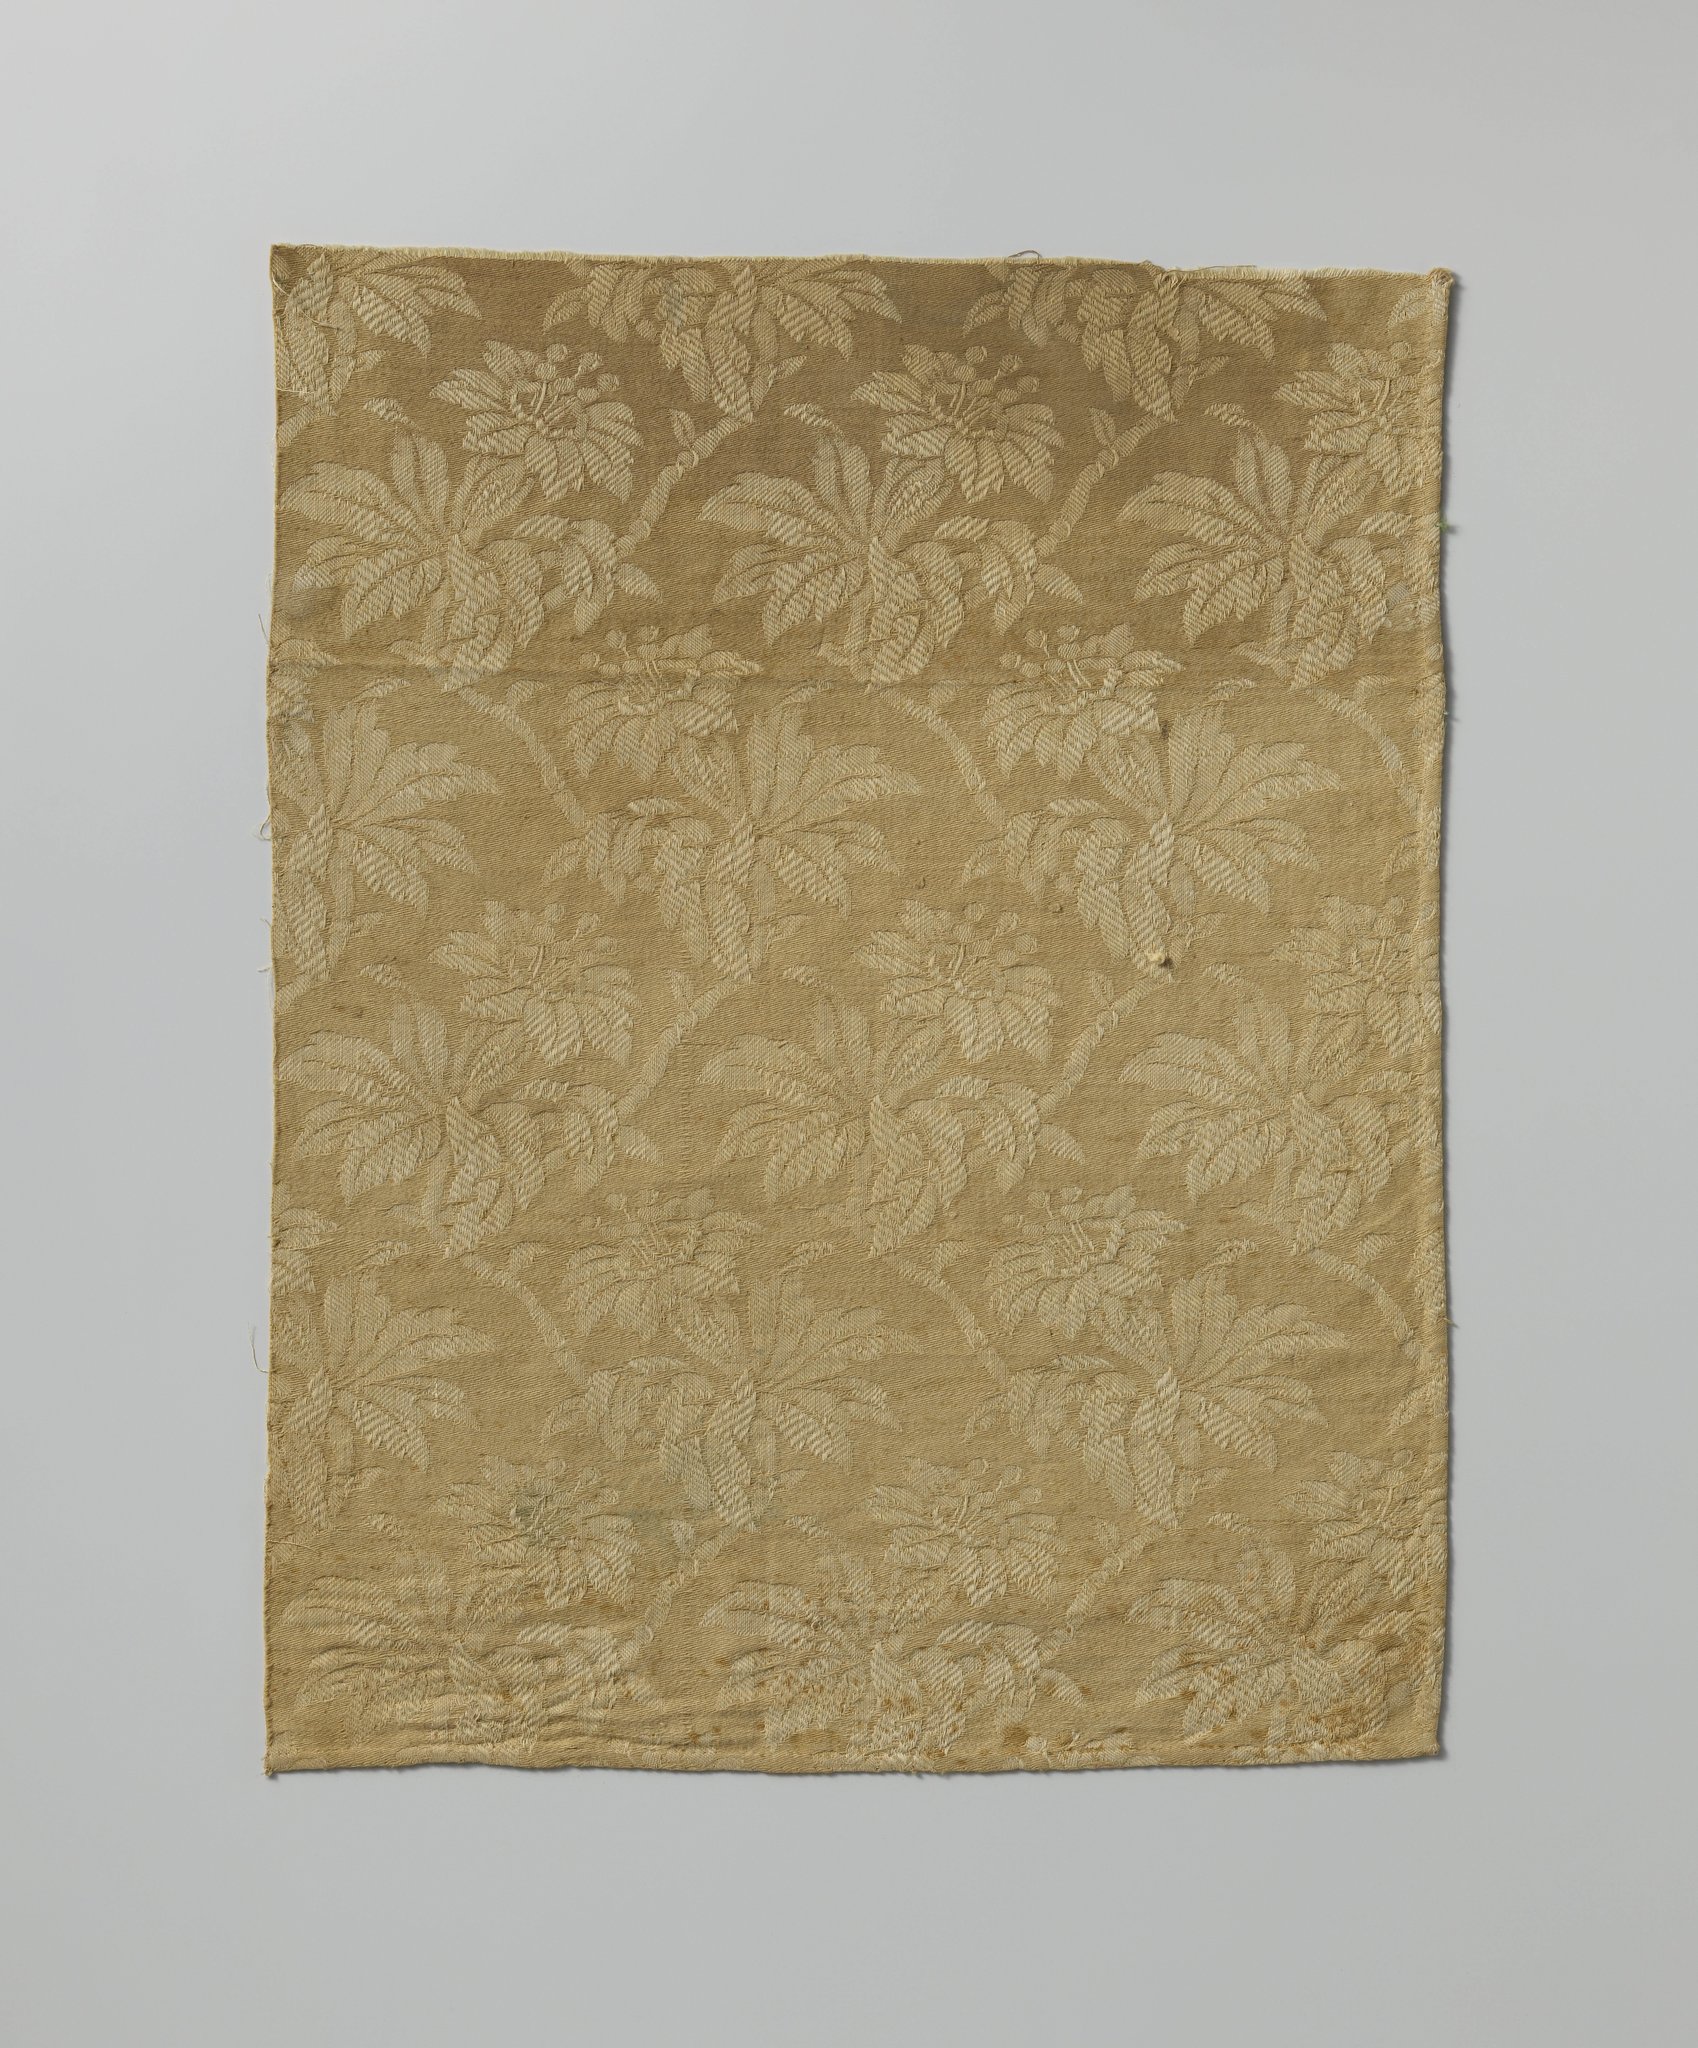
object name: fragment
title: Fragment van een katoenen weefsel (wandbespanning?)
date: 1770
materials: cotton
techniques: weave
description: Fragment van een complex weefsel van katoen. Het weefsel heeft een oranje/bruine kleur met een patroon van bloemtakken in een crèmekleur.